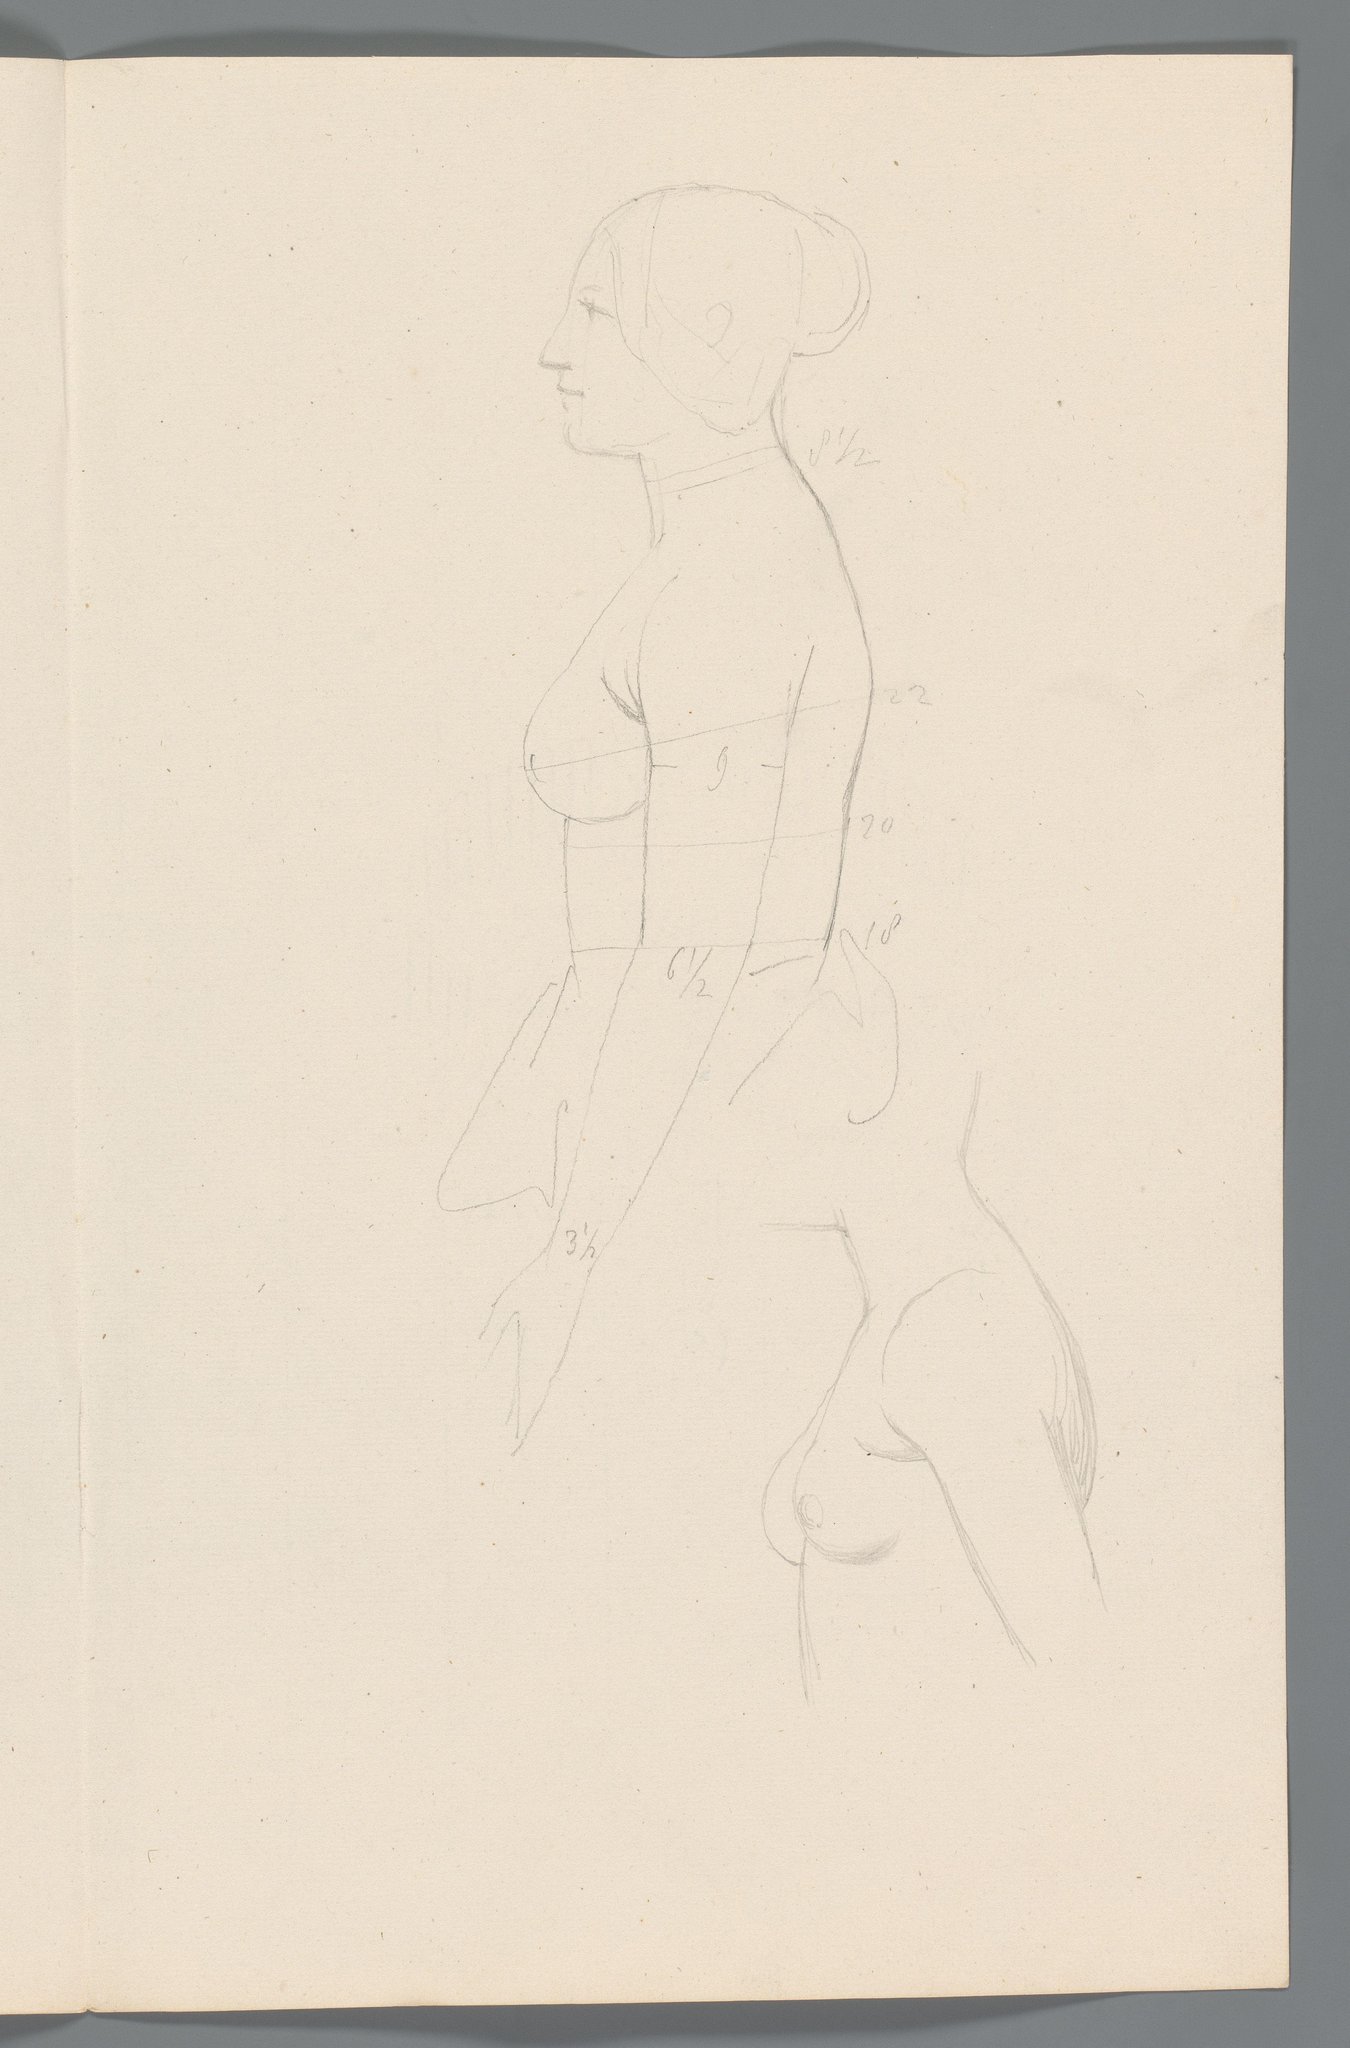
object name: drawing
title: Studie van het bovenlichaam van een vrouw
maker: jacobus everhardus josephus van den berg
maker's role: draughtsman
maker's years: 1802-1861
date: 1853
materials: paper, pencil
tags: standing figure (canon, proportions) - aa - female human figure, anatomy (non-medical) - aa - female human figure, chest, bust - aa - female human figure